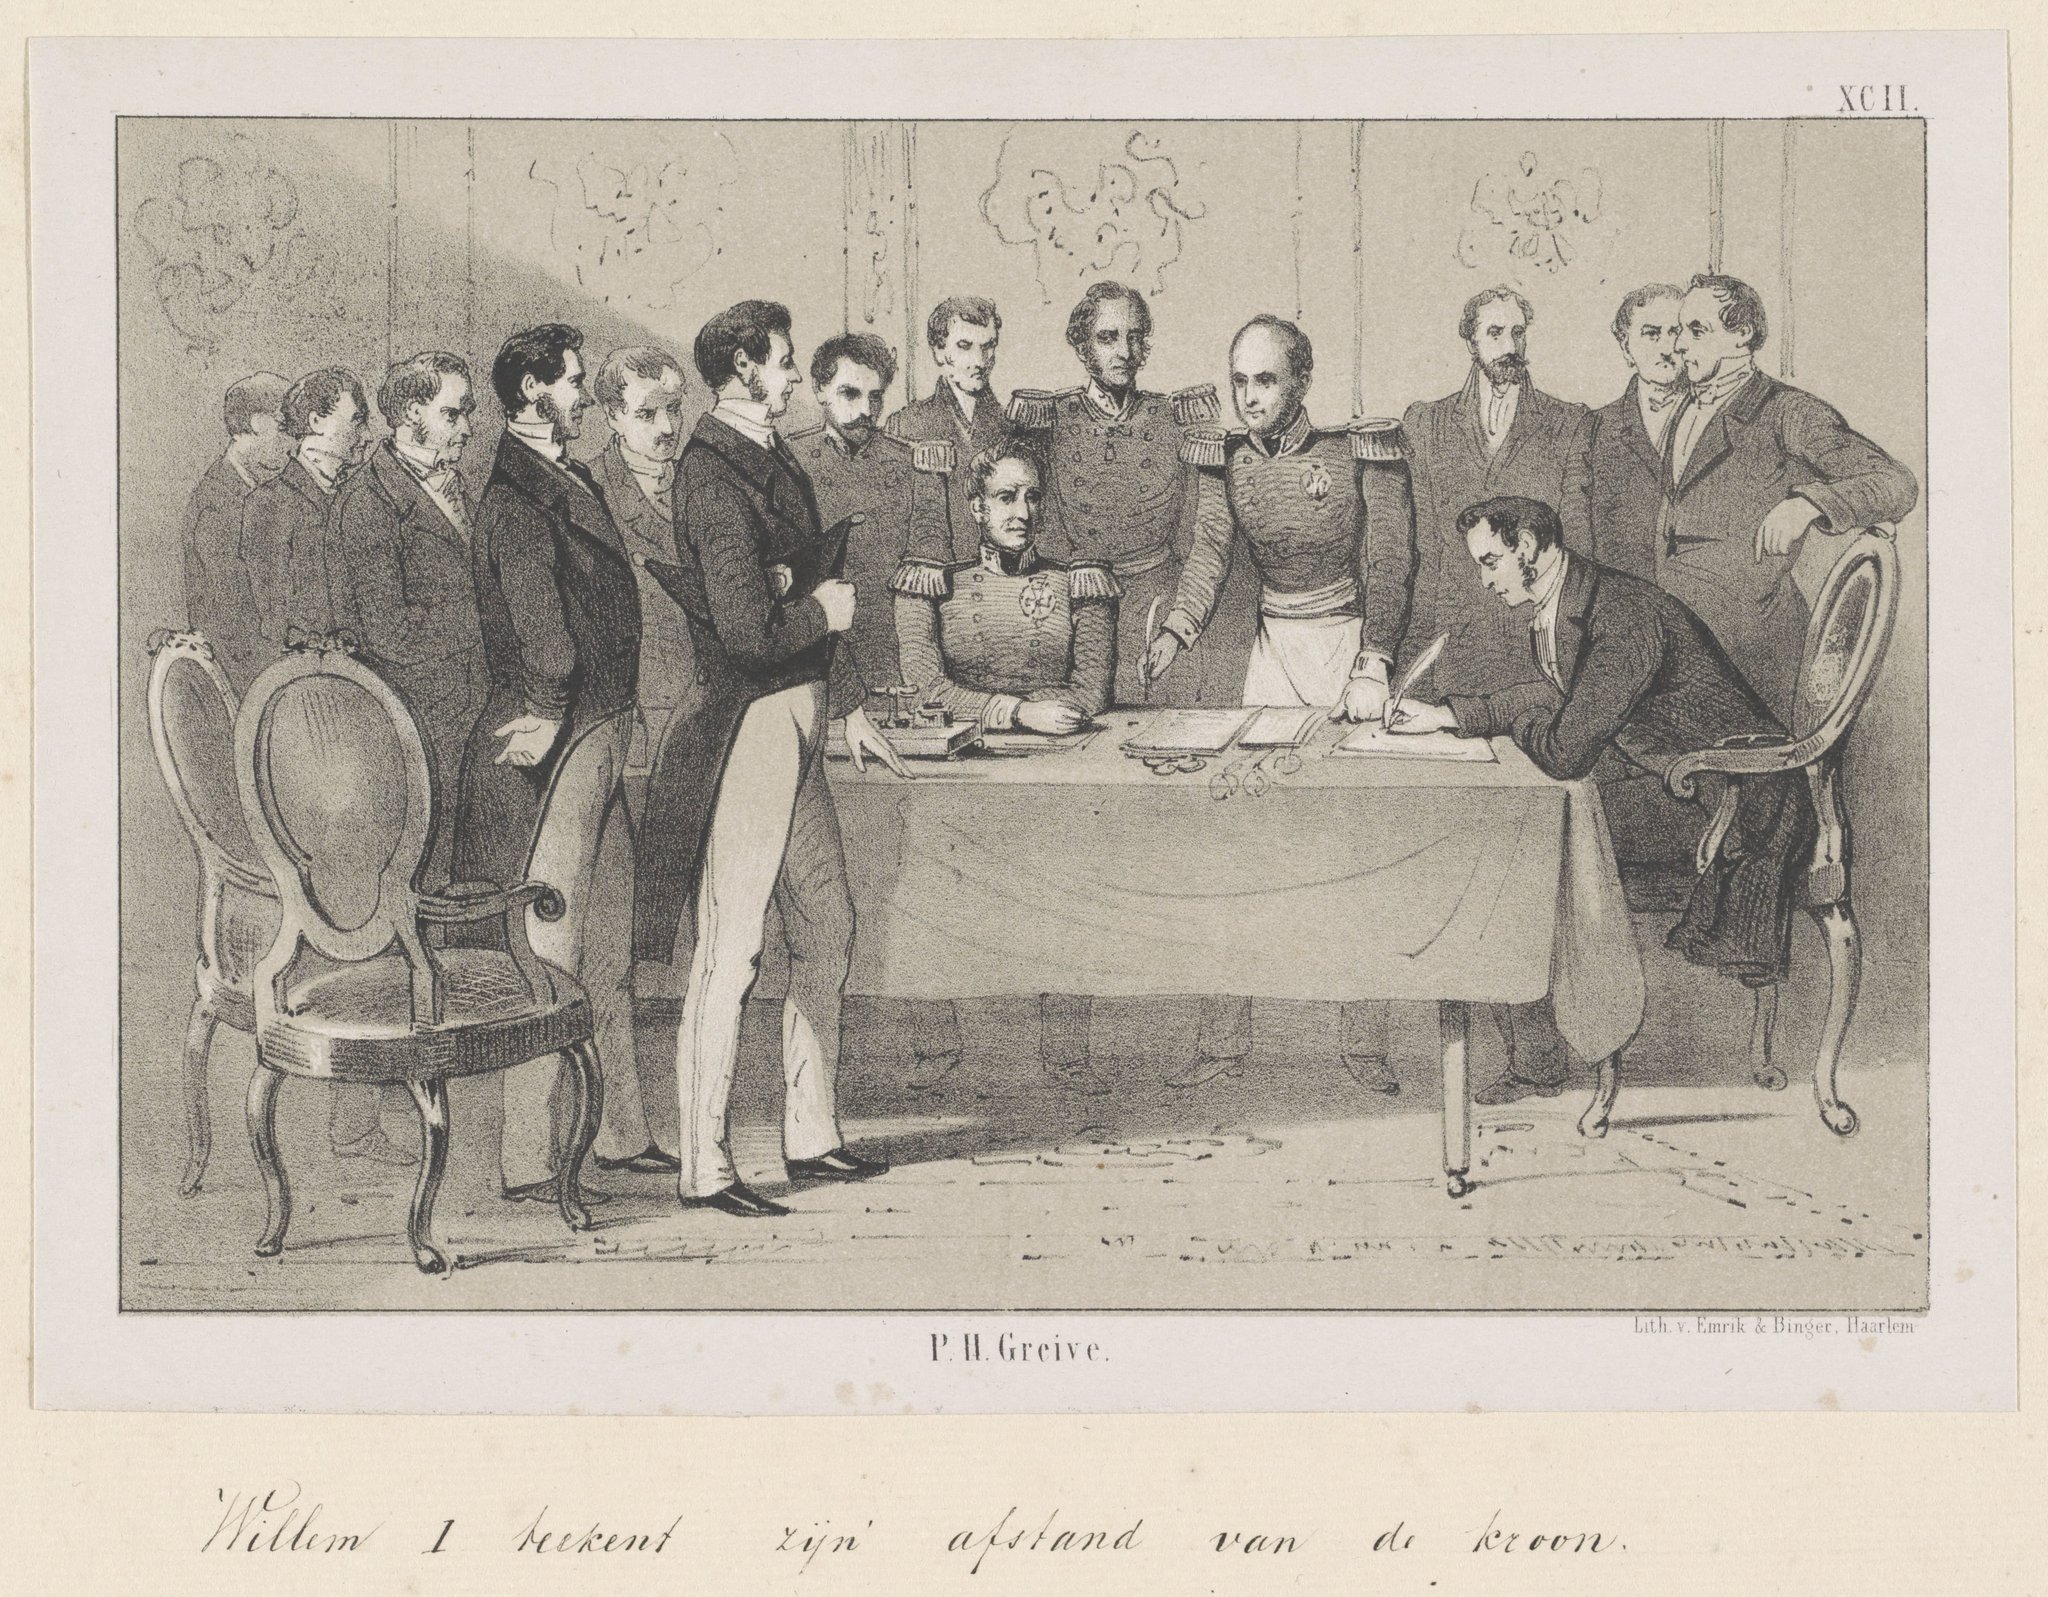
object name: history print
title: Abdicatie van Willem I, 1840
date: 1853-1861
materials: paper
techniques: tone lithography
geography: netherlands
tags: the hague, berlin, william i of the netherlands, william ii of the netherlands, voluntary abdication (of a ruler) - bb - female ruler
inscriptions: collector's mark: Lugt 2228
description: Dit nummer is een door het RPK toegevoegd nummer en staat niet in Frederik Muller, het werk waar de prent voor is gemaakt of uit afkomstig is, staat wel vermeld in Frederik Muller. Gebruikt als illustratie in: Jacob van Lennep, De geschiedenis des vaderlands in schetsen en afbeeldingen, Binger, Amsterdam 1855-1861, 8 delen, pl. XCII.